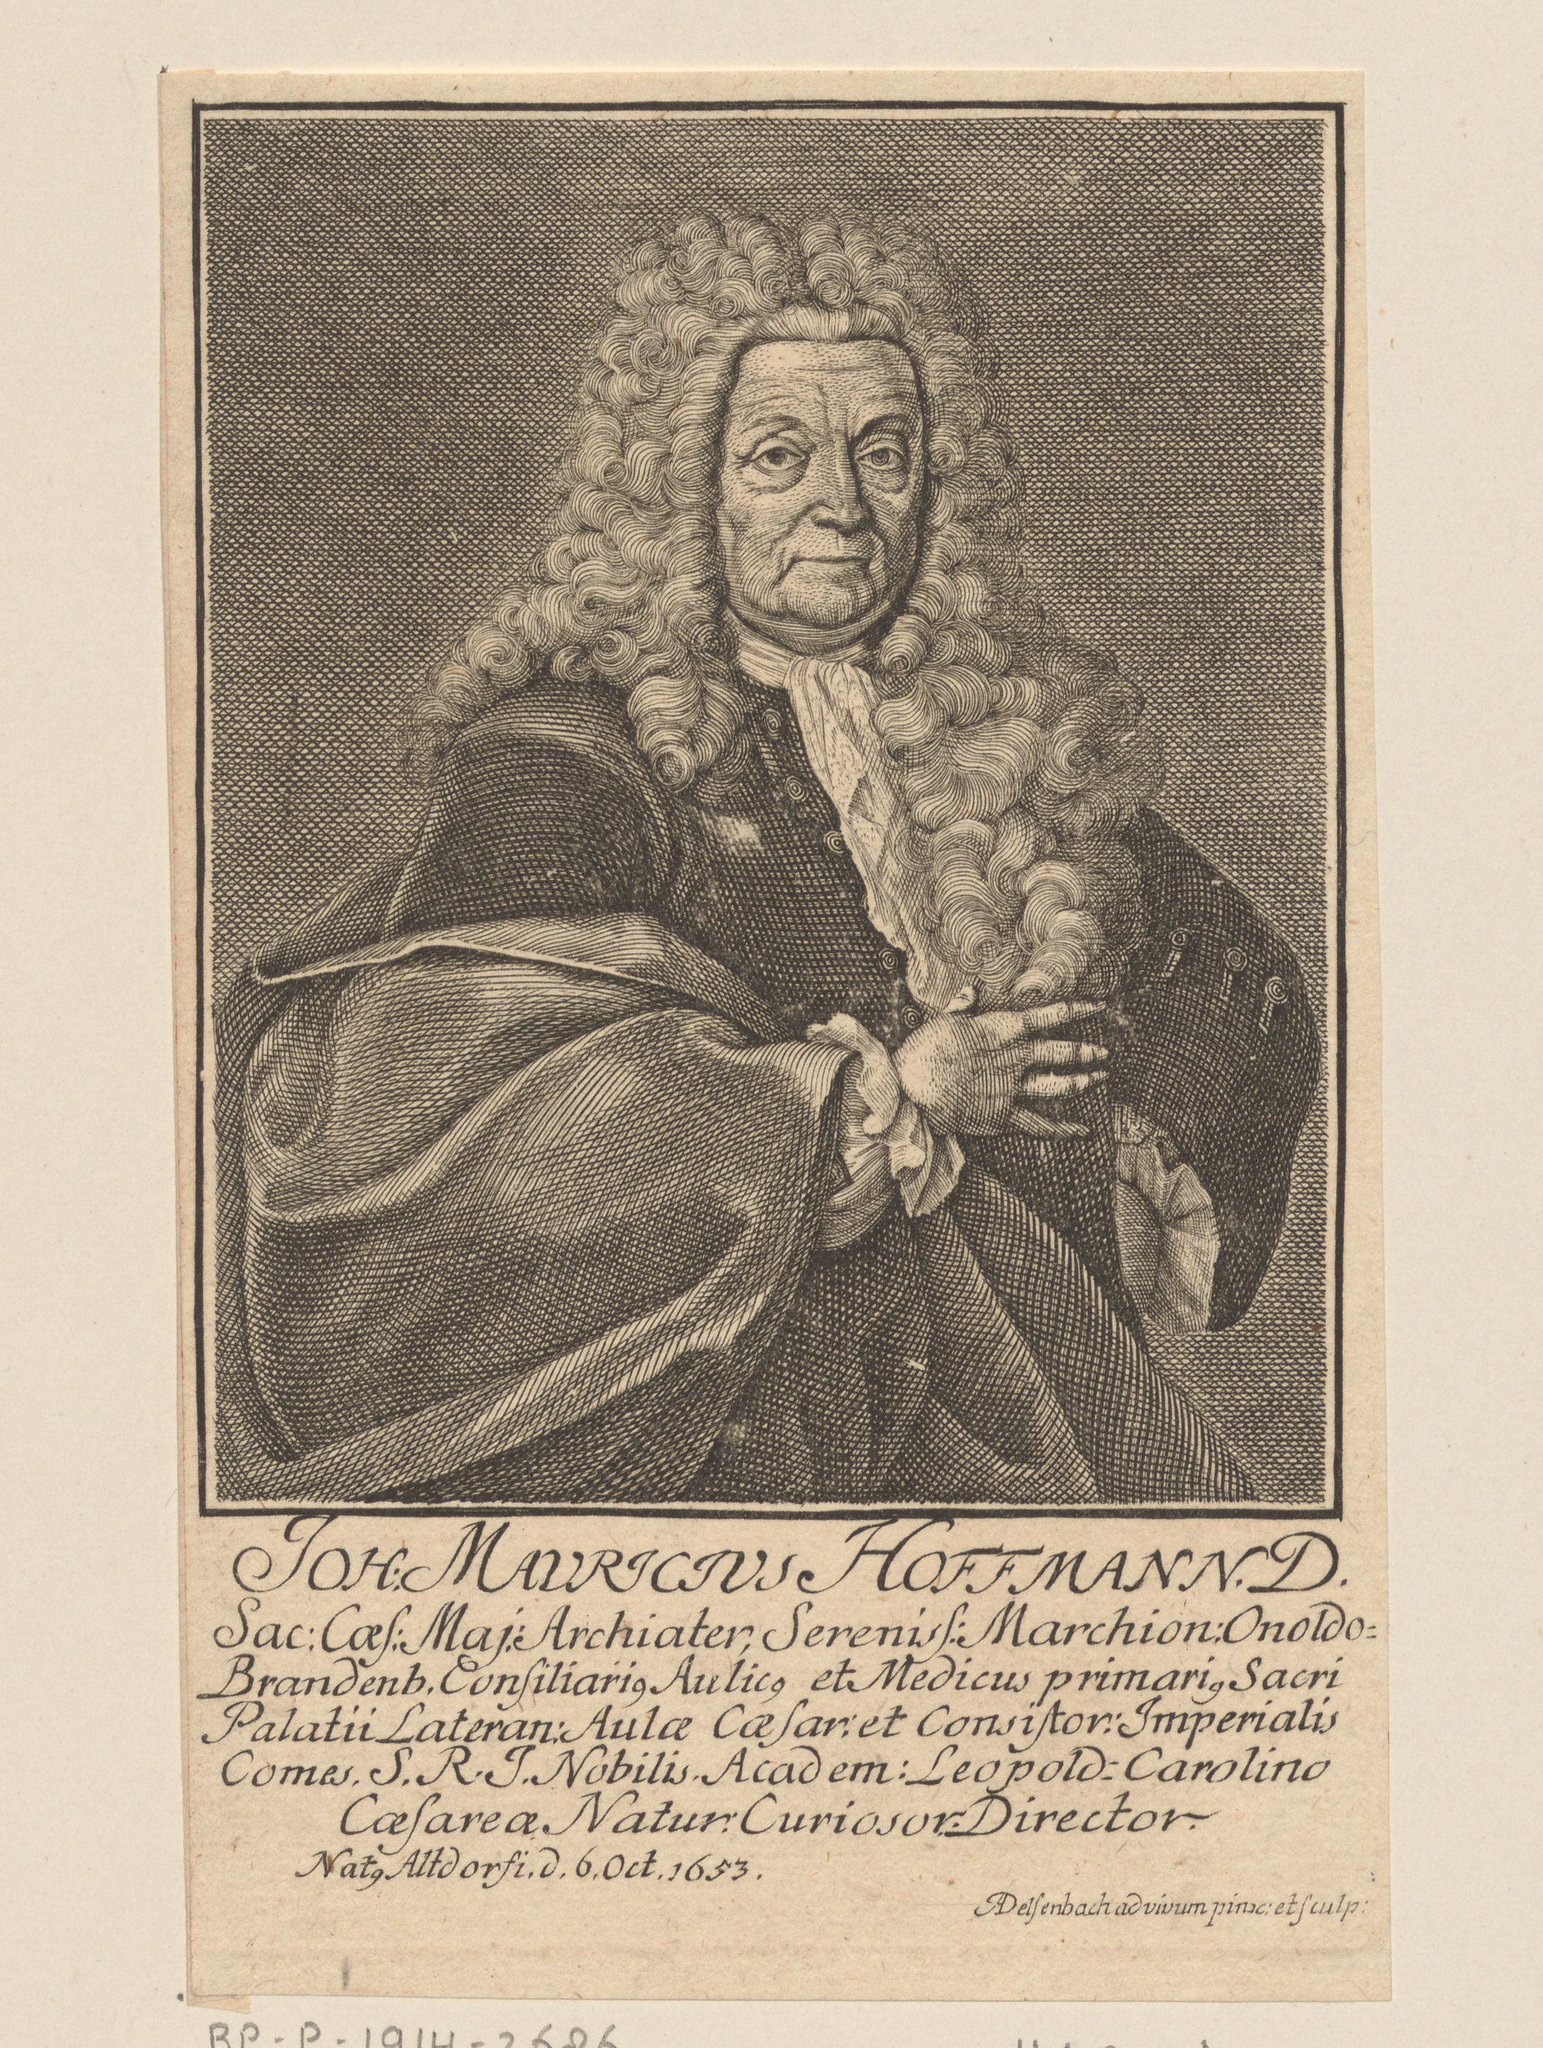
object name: print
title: Portret van Johann Moritz Hoffmann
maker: johann adam delsenbach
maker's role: print maker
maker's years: 1687-1765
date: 1697-1765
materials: paper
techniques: engraving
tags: historical persons, physician, doctor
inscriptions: collector's mark: Lugt 2228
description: Prent mogelijk gebruikt in: Fränckische Acta erudita et curiosa (...). Neurenberg: erven Wolfgang Moritz Endter en Julius Arnold Engelbrecht, 1726, dl. 3.